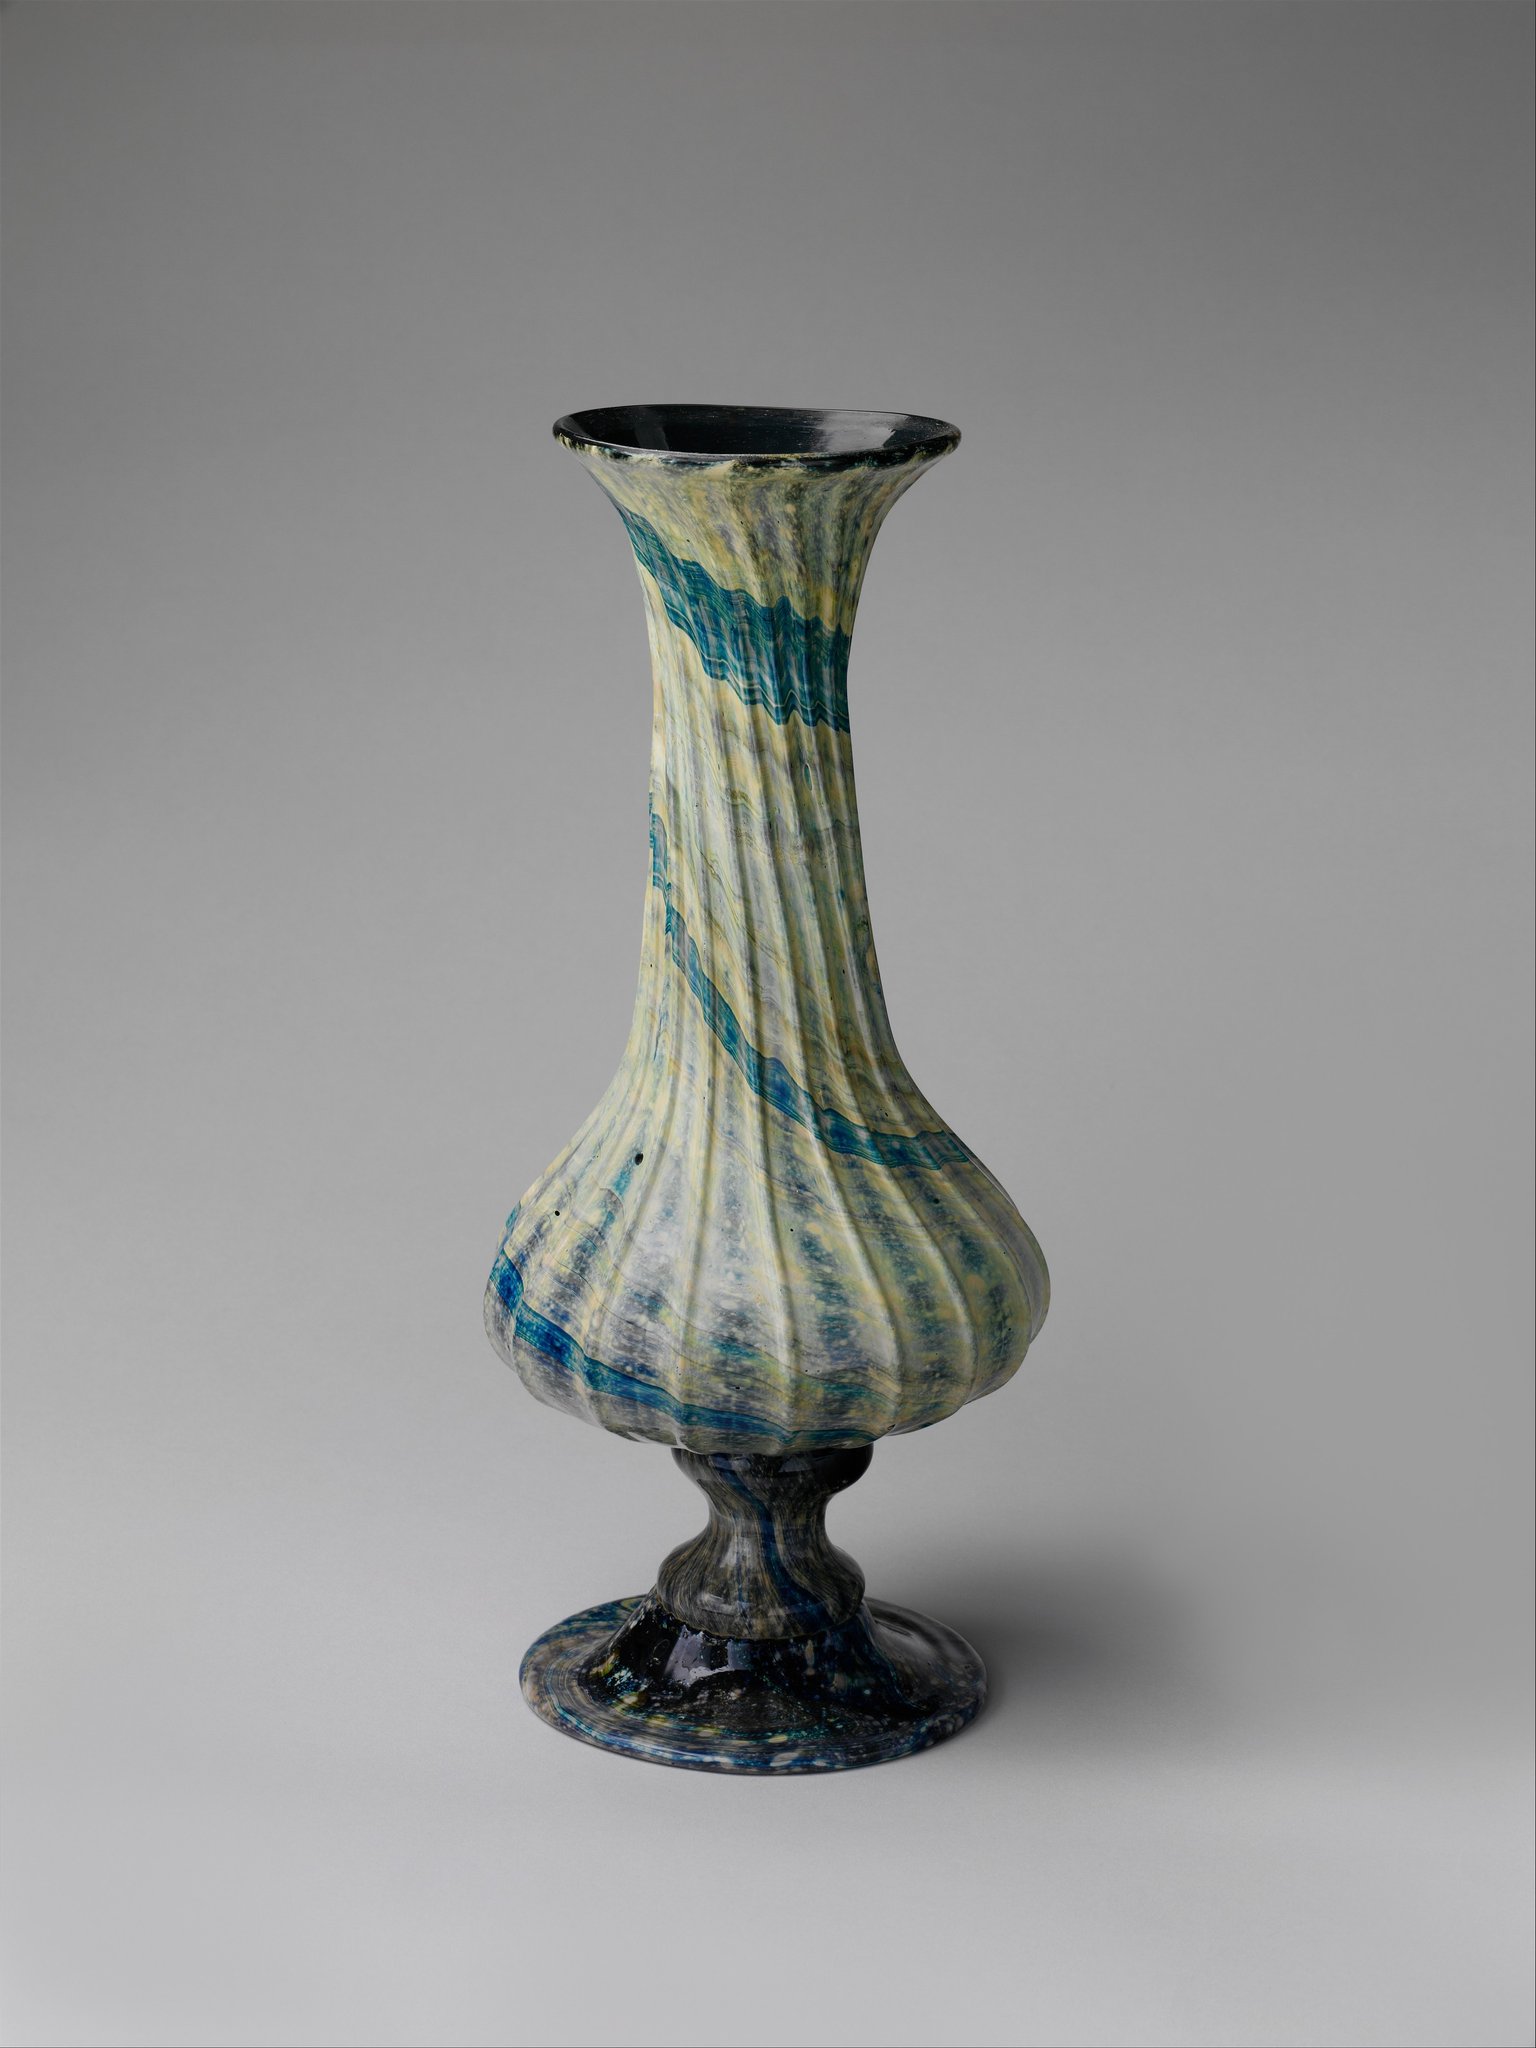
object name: vase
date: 1801-1900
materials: glass